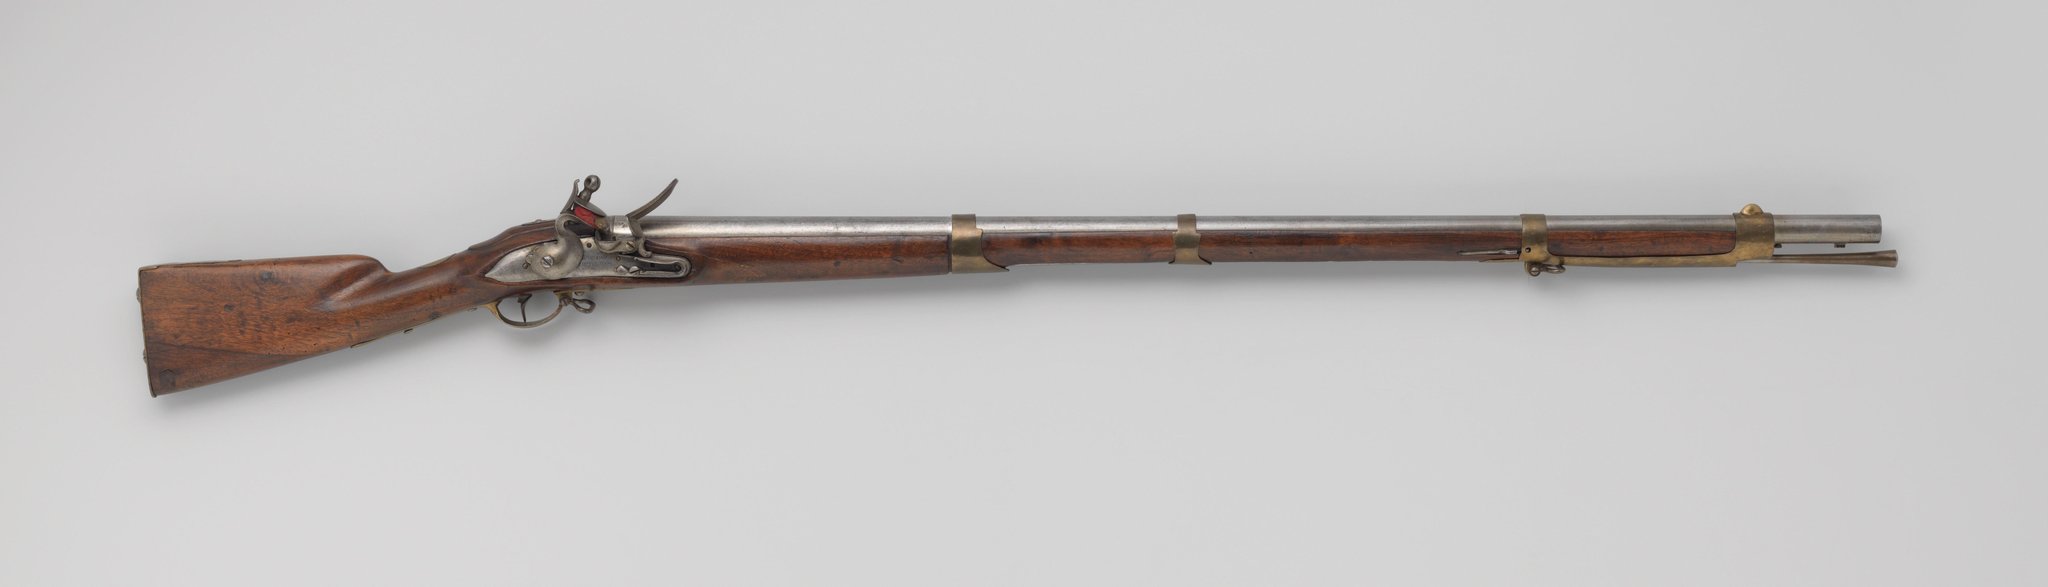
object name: flintlock pistol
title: Vuursteengeweer Staatse leger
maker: johannes rousseau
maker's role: geweermaker, pistoolmaker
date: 1780-1805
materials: brass, iron, wood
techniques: printing, engraving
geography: amsterdam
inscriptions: coat of arms: ‘PIF; NR (cf. St. 4170)’, : ‘GB (St. 2564)’, signature: ‘I.ROUSSEAU // AMSTERDAM’